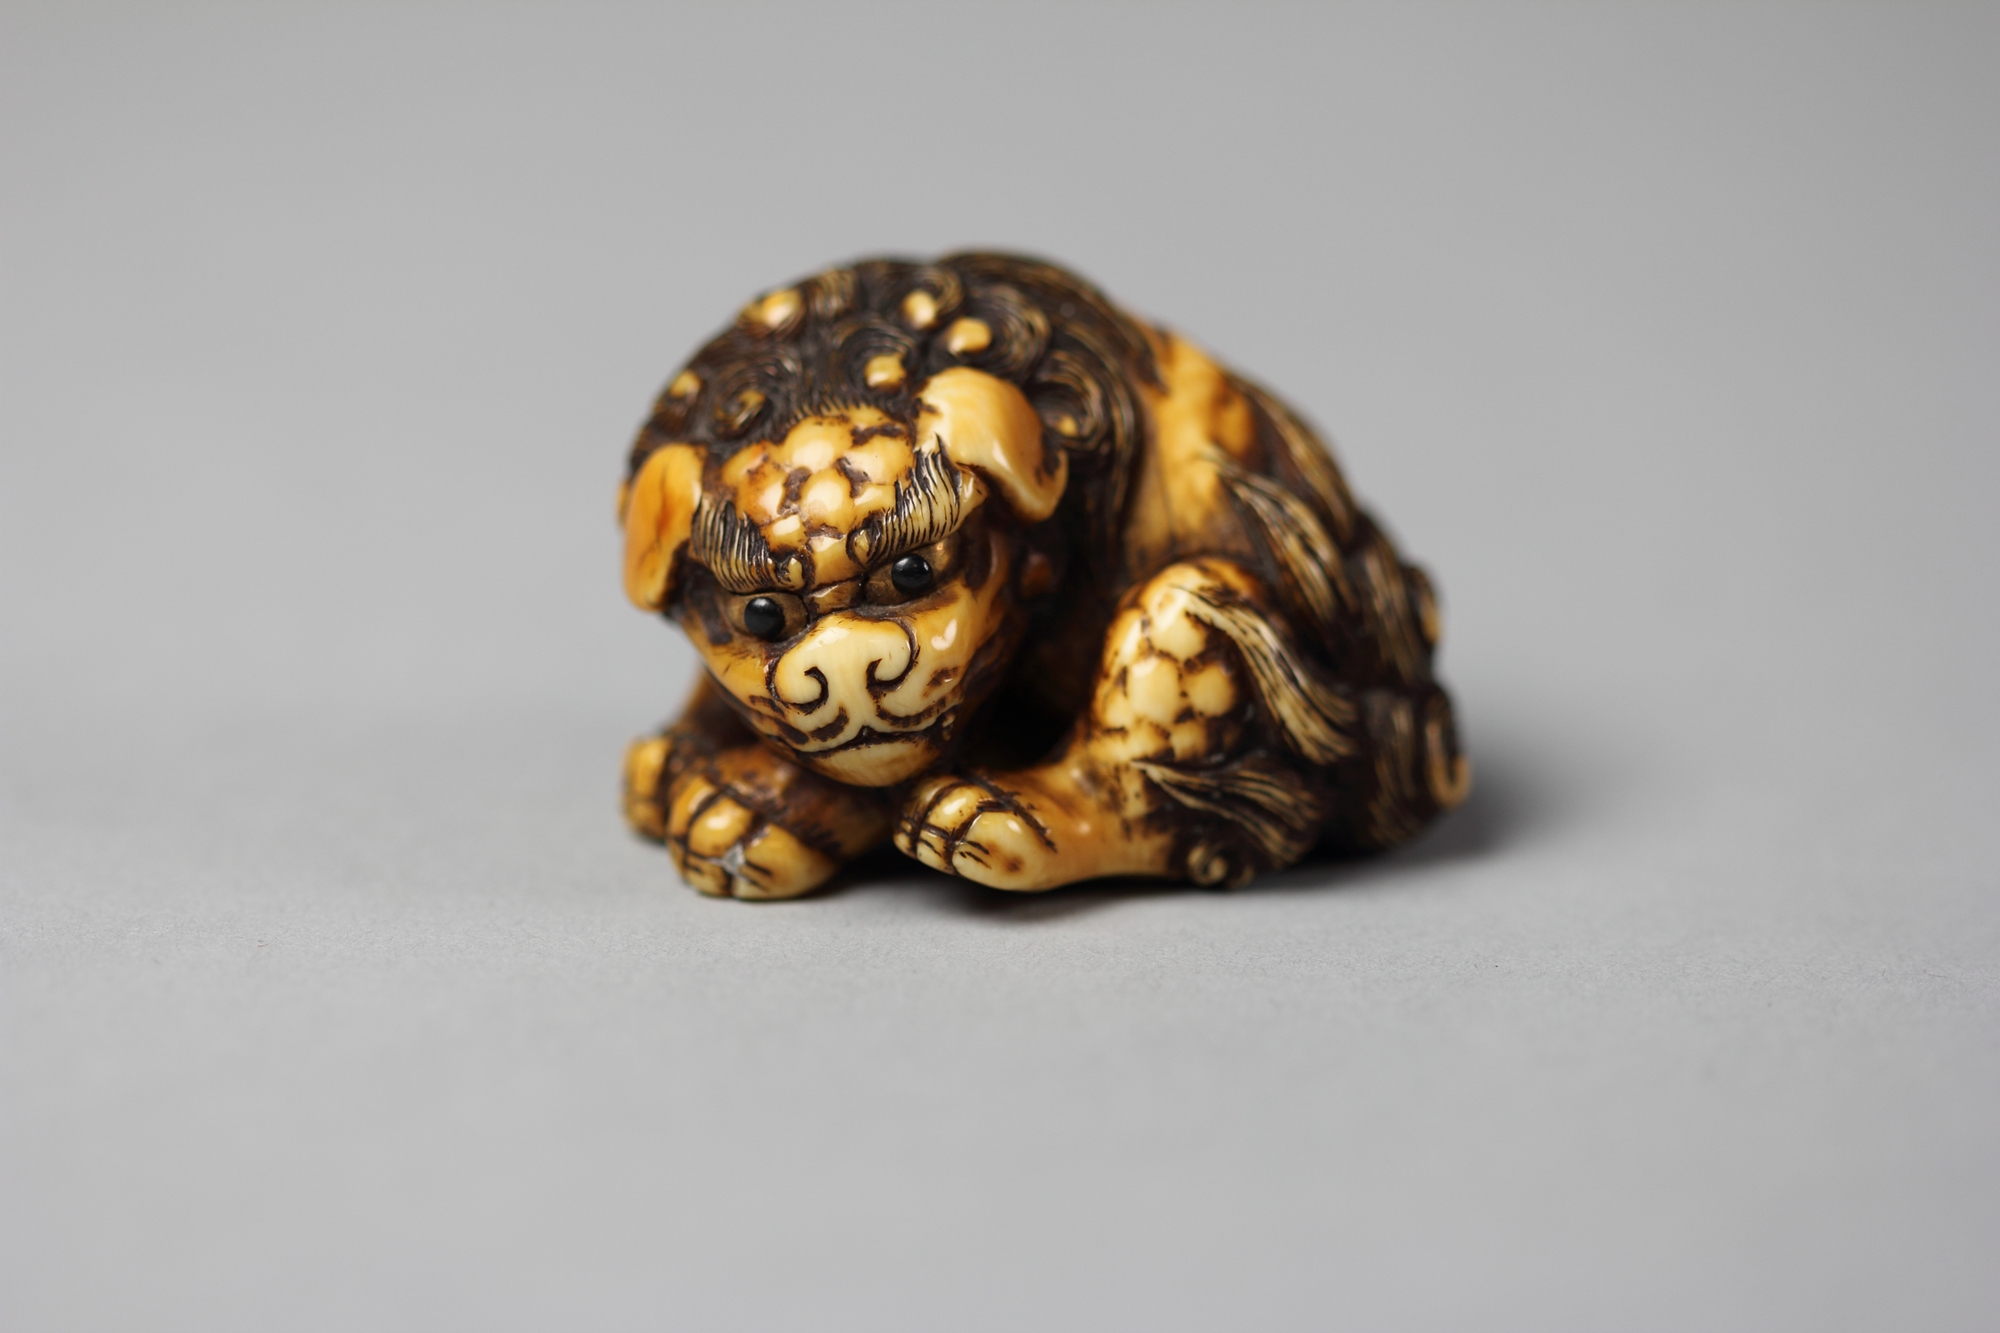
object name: netsuke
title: Netsuke of a Karashishi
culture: japanese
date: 1767-1833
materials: gold, ivory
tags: dogs